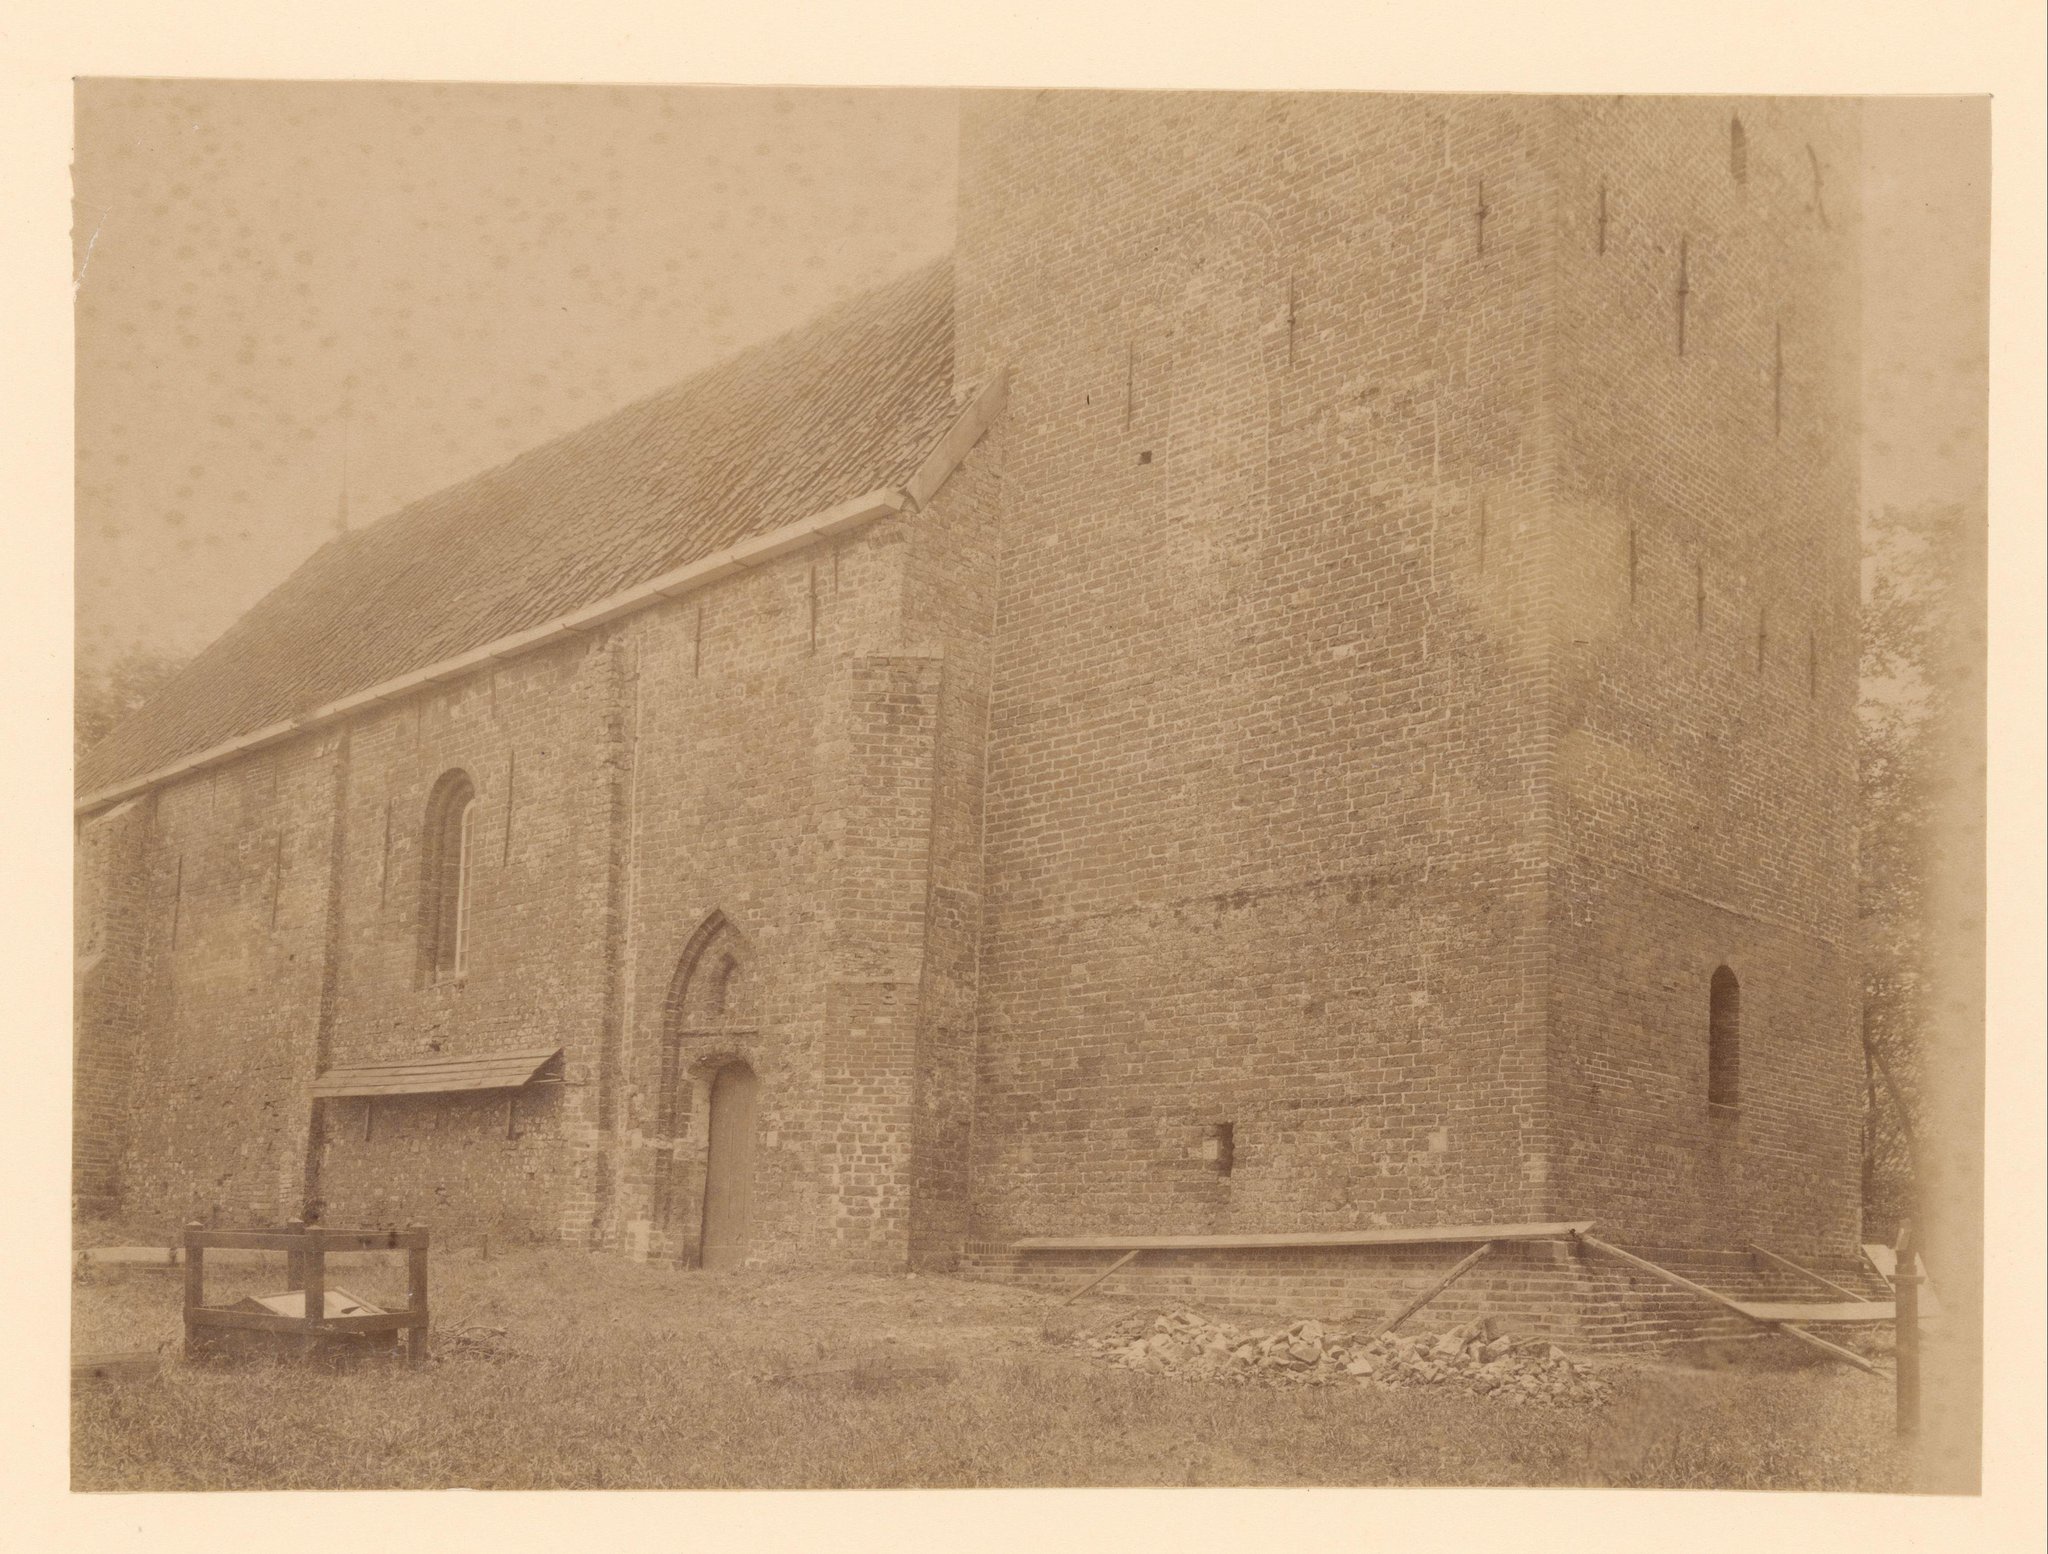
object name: photograph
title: Noordwestzijde van de Hervormde Kerk te Westerwijtwerd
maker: anoniem (monumentenzorg)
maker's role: fotograaf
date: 1897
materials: cardboard, photographic support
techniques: albumen print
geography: westerwijtwerd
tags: church (exterior)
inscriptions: annotation: ‘Kerk te Westerwijtwerd/ N.W. aangezicht juli 1897/ gem. Middelstum’, annotation: ‘Westerwijtwerd/ gem. Middelstum’